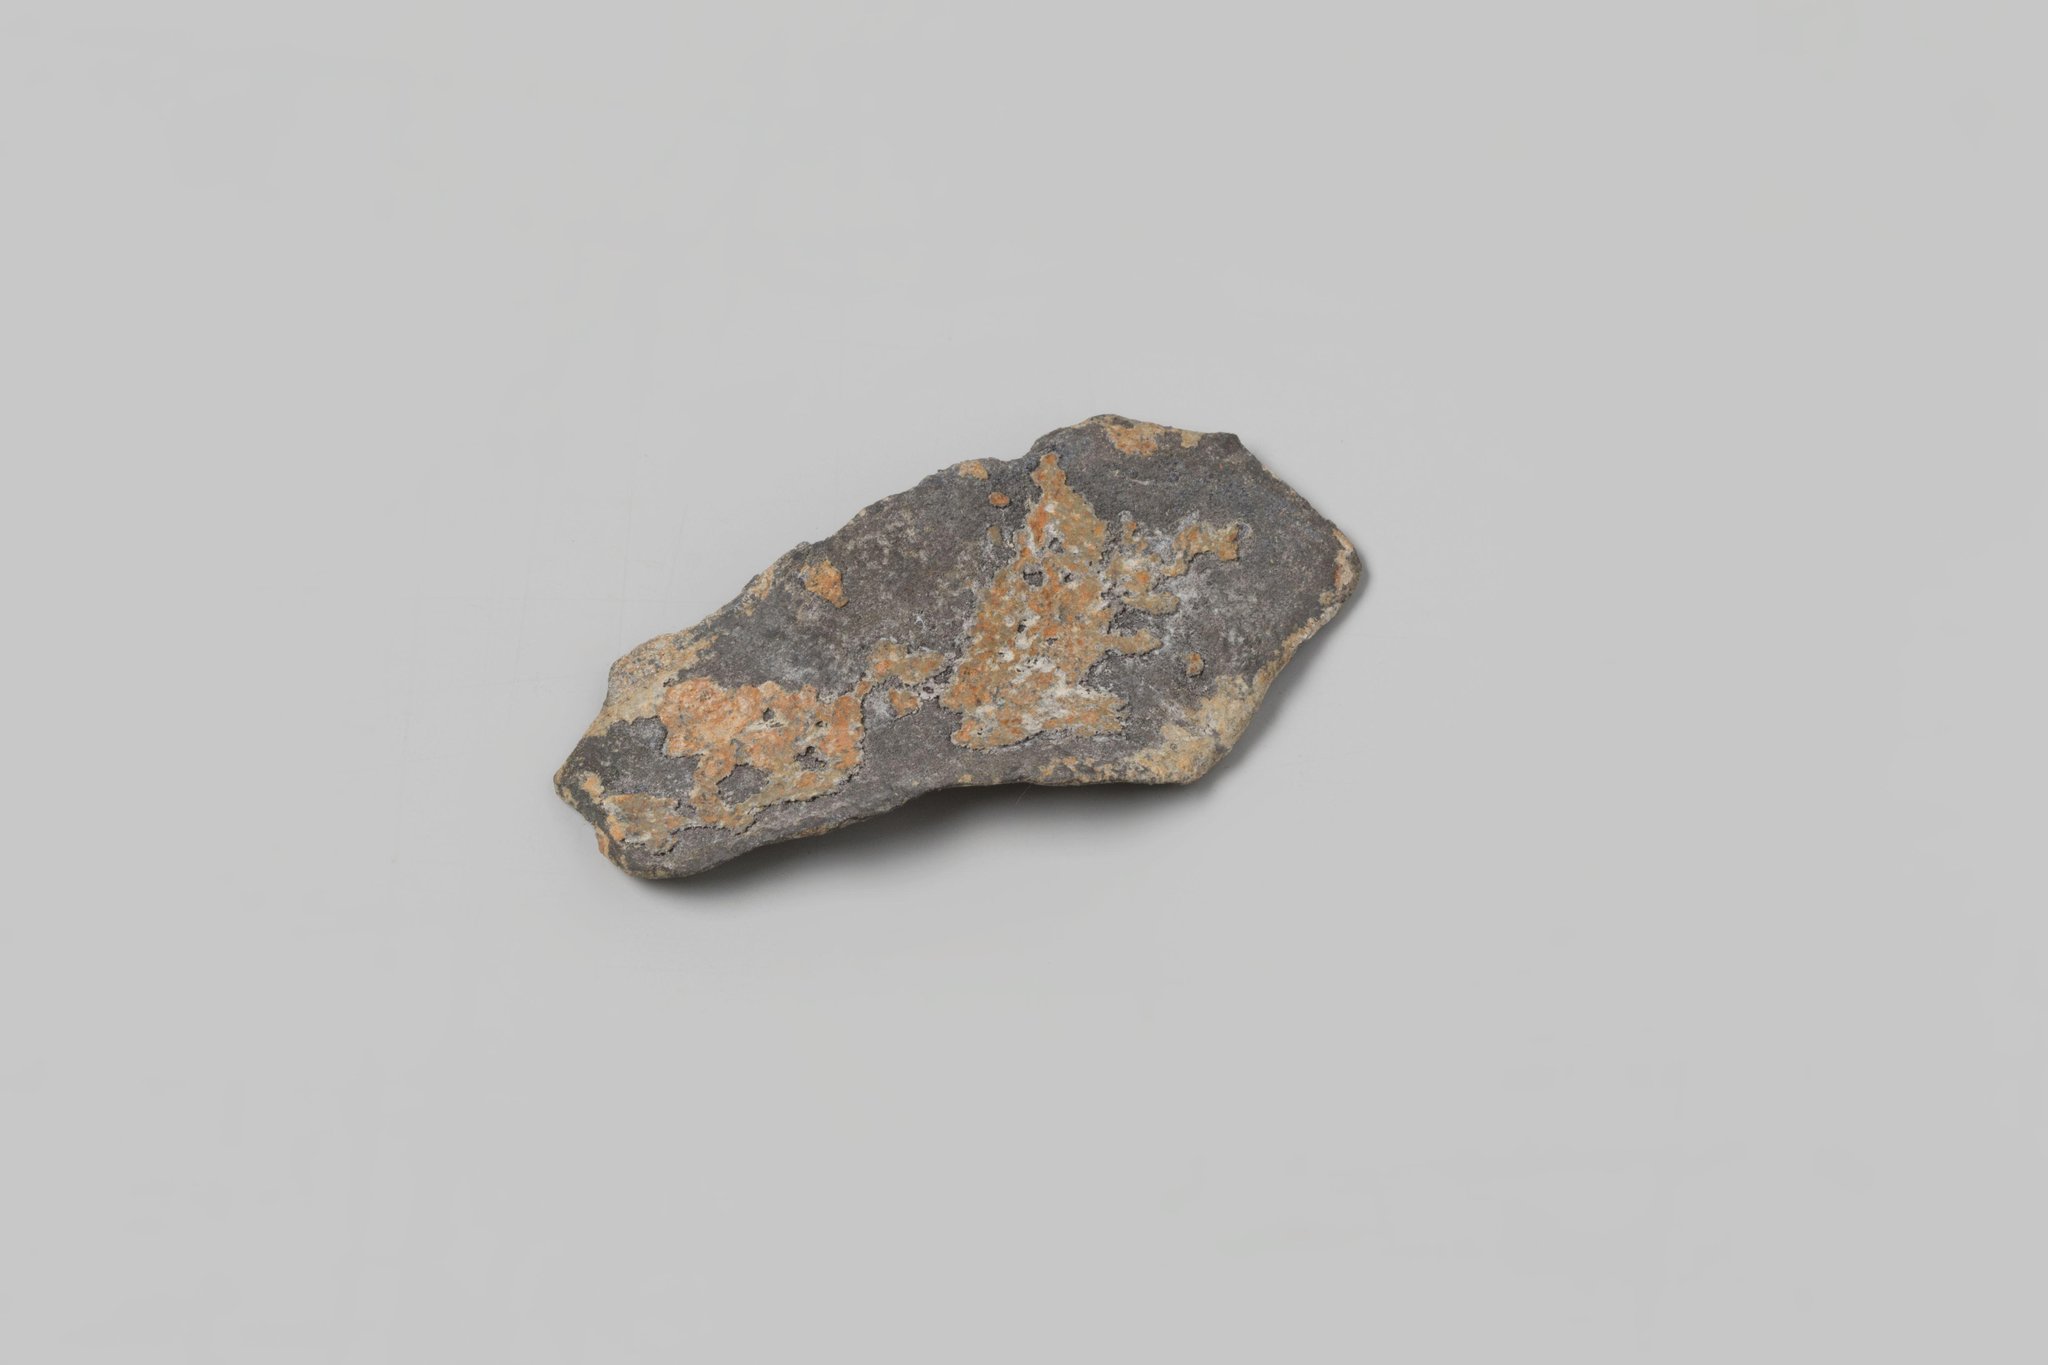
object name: fragment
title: Fragment lood uit het wrak van de Oost-Indiëvaarder Hollandia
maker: Anonymous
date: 1700-1743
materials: lead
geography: netherlands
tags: verenigde oostindische compagnie, hollandia (schip), annet